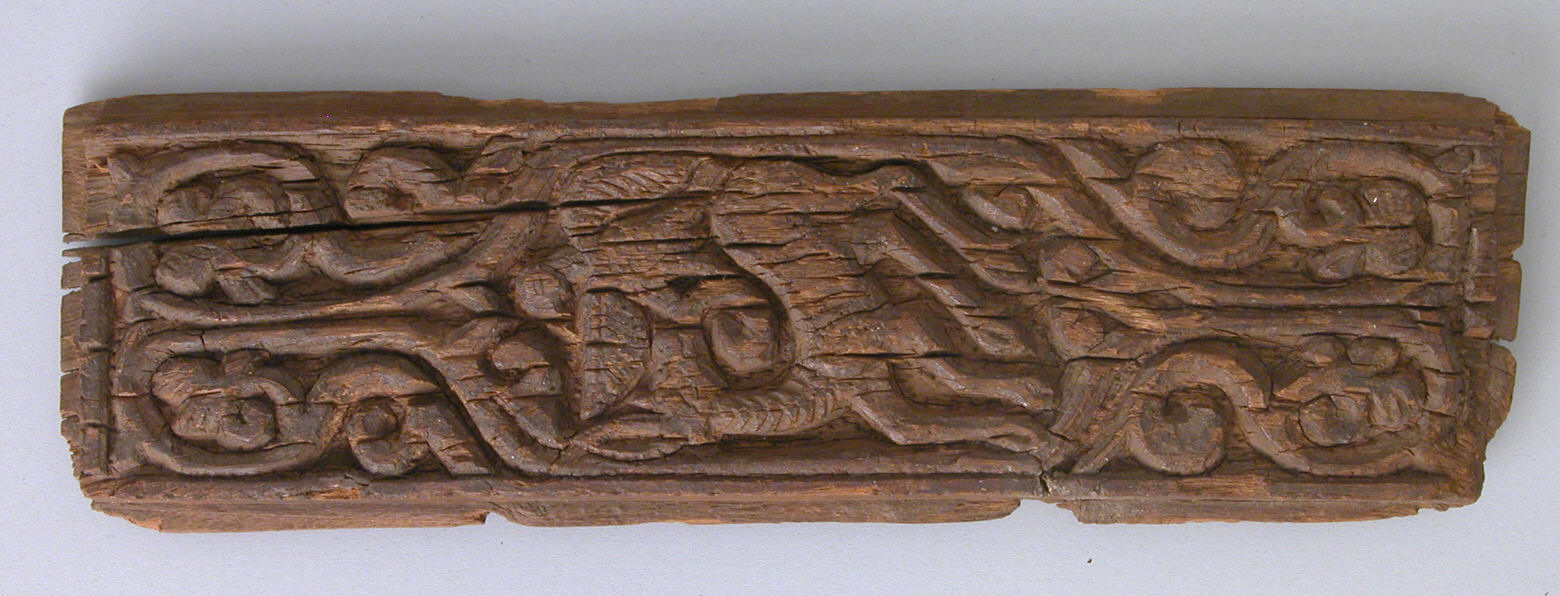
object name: panel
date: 901-1100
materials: wood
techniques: carving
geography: egypt